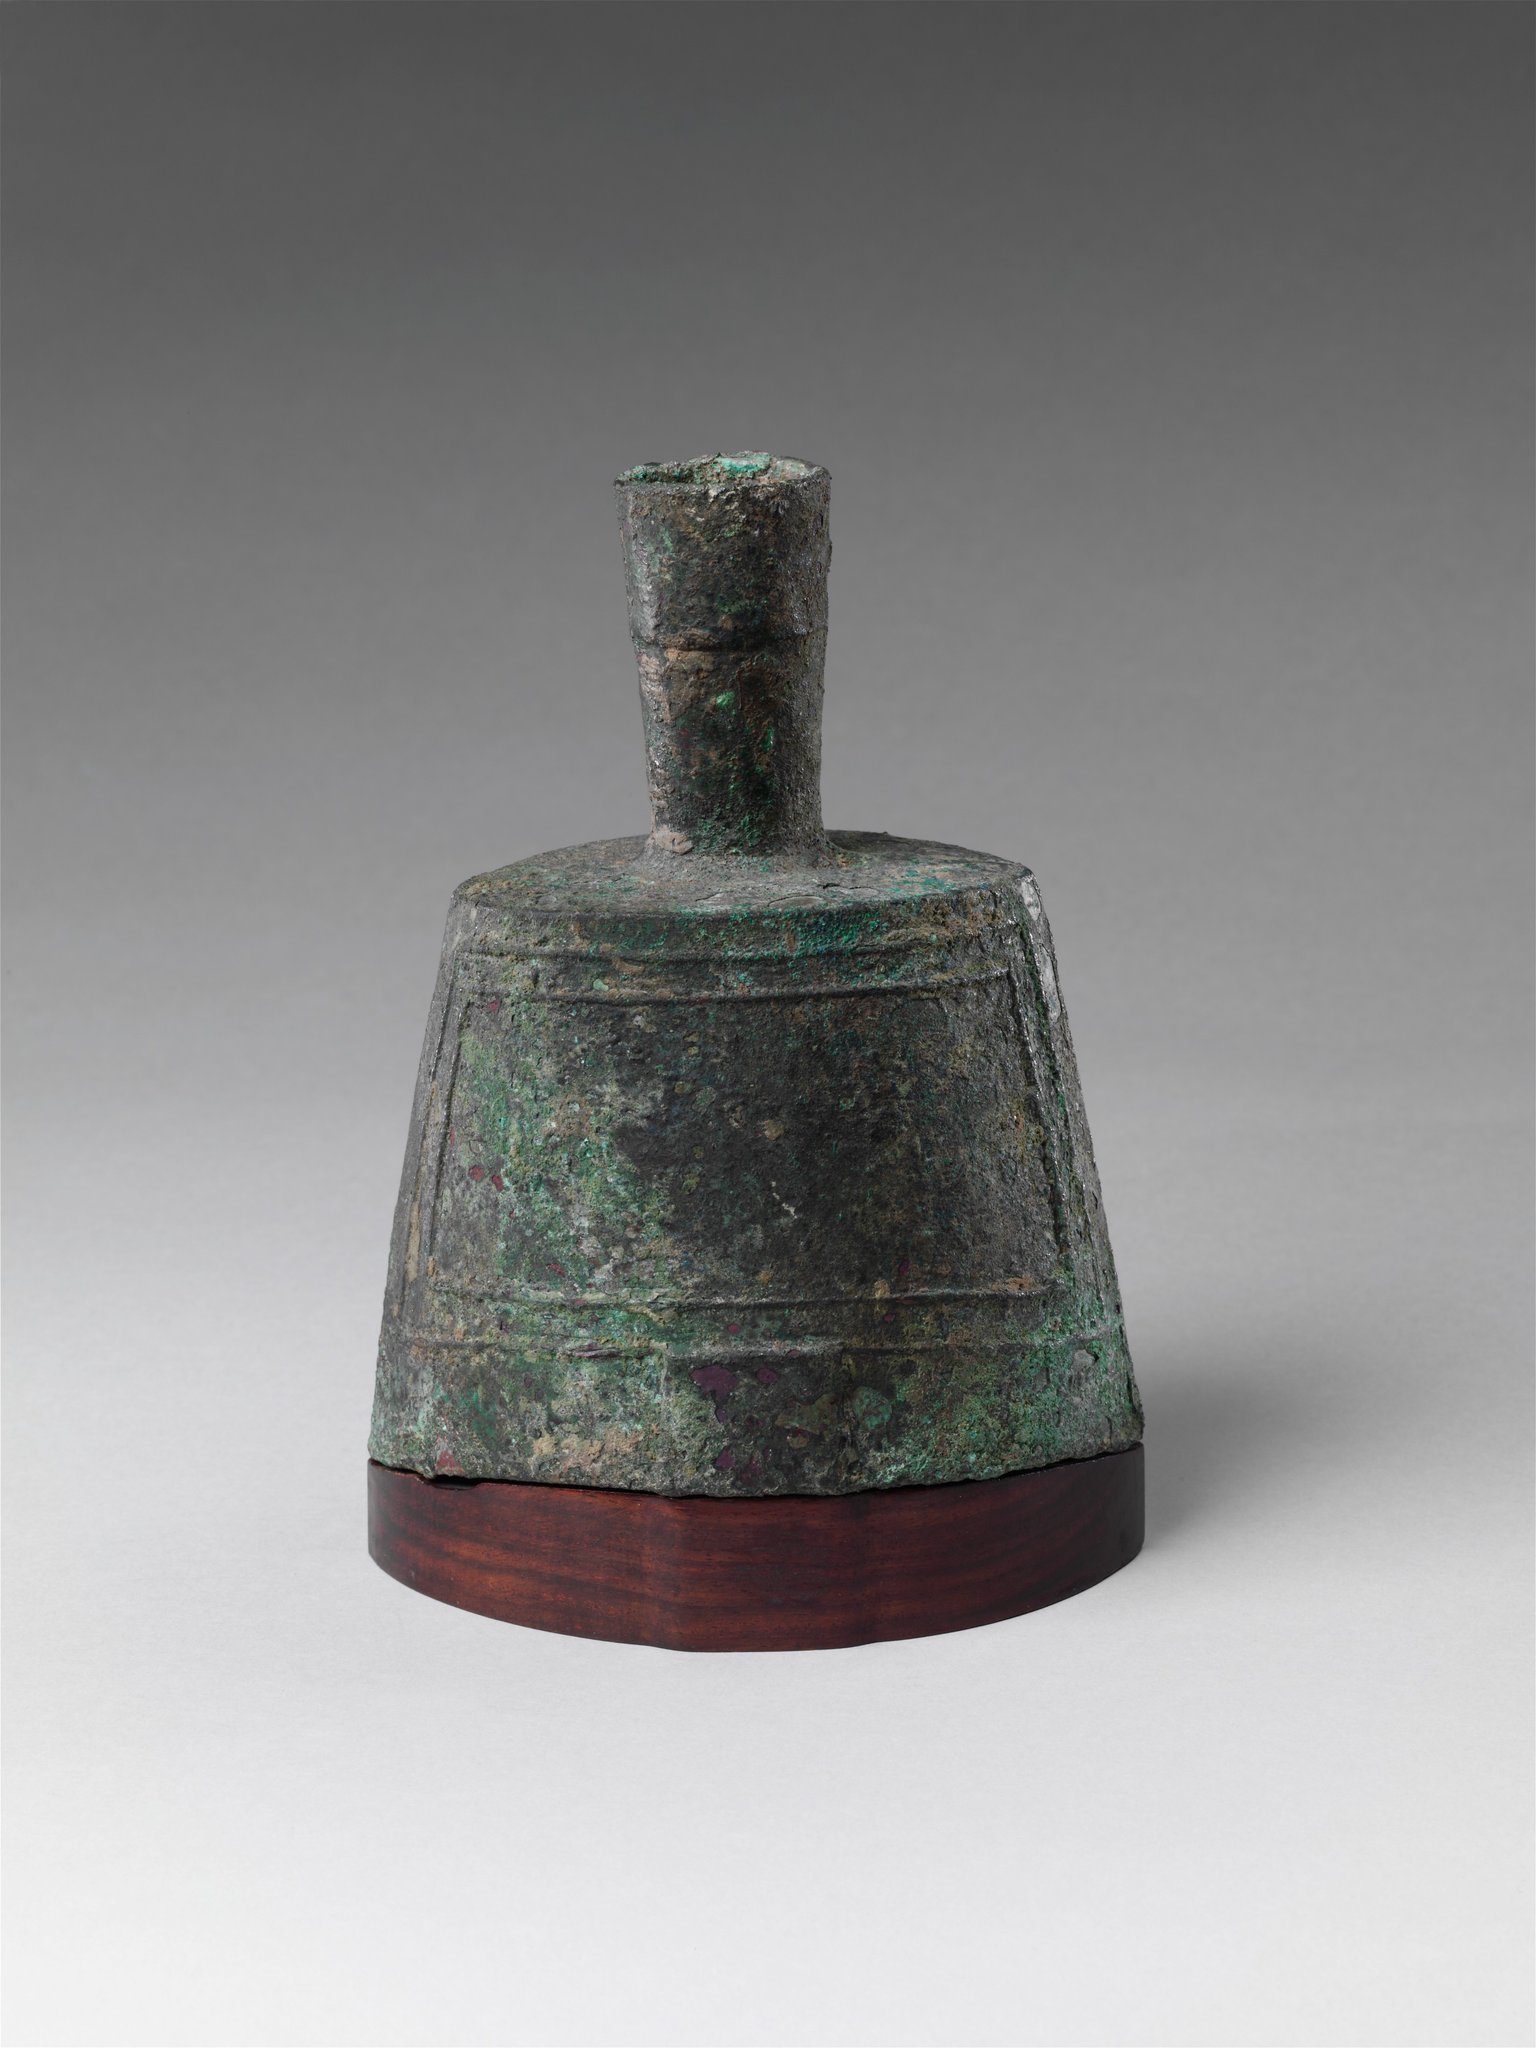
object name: bell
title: Bell （Zheng）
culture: chinese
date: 500-201 BCE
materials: bronze